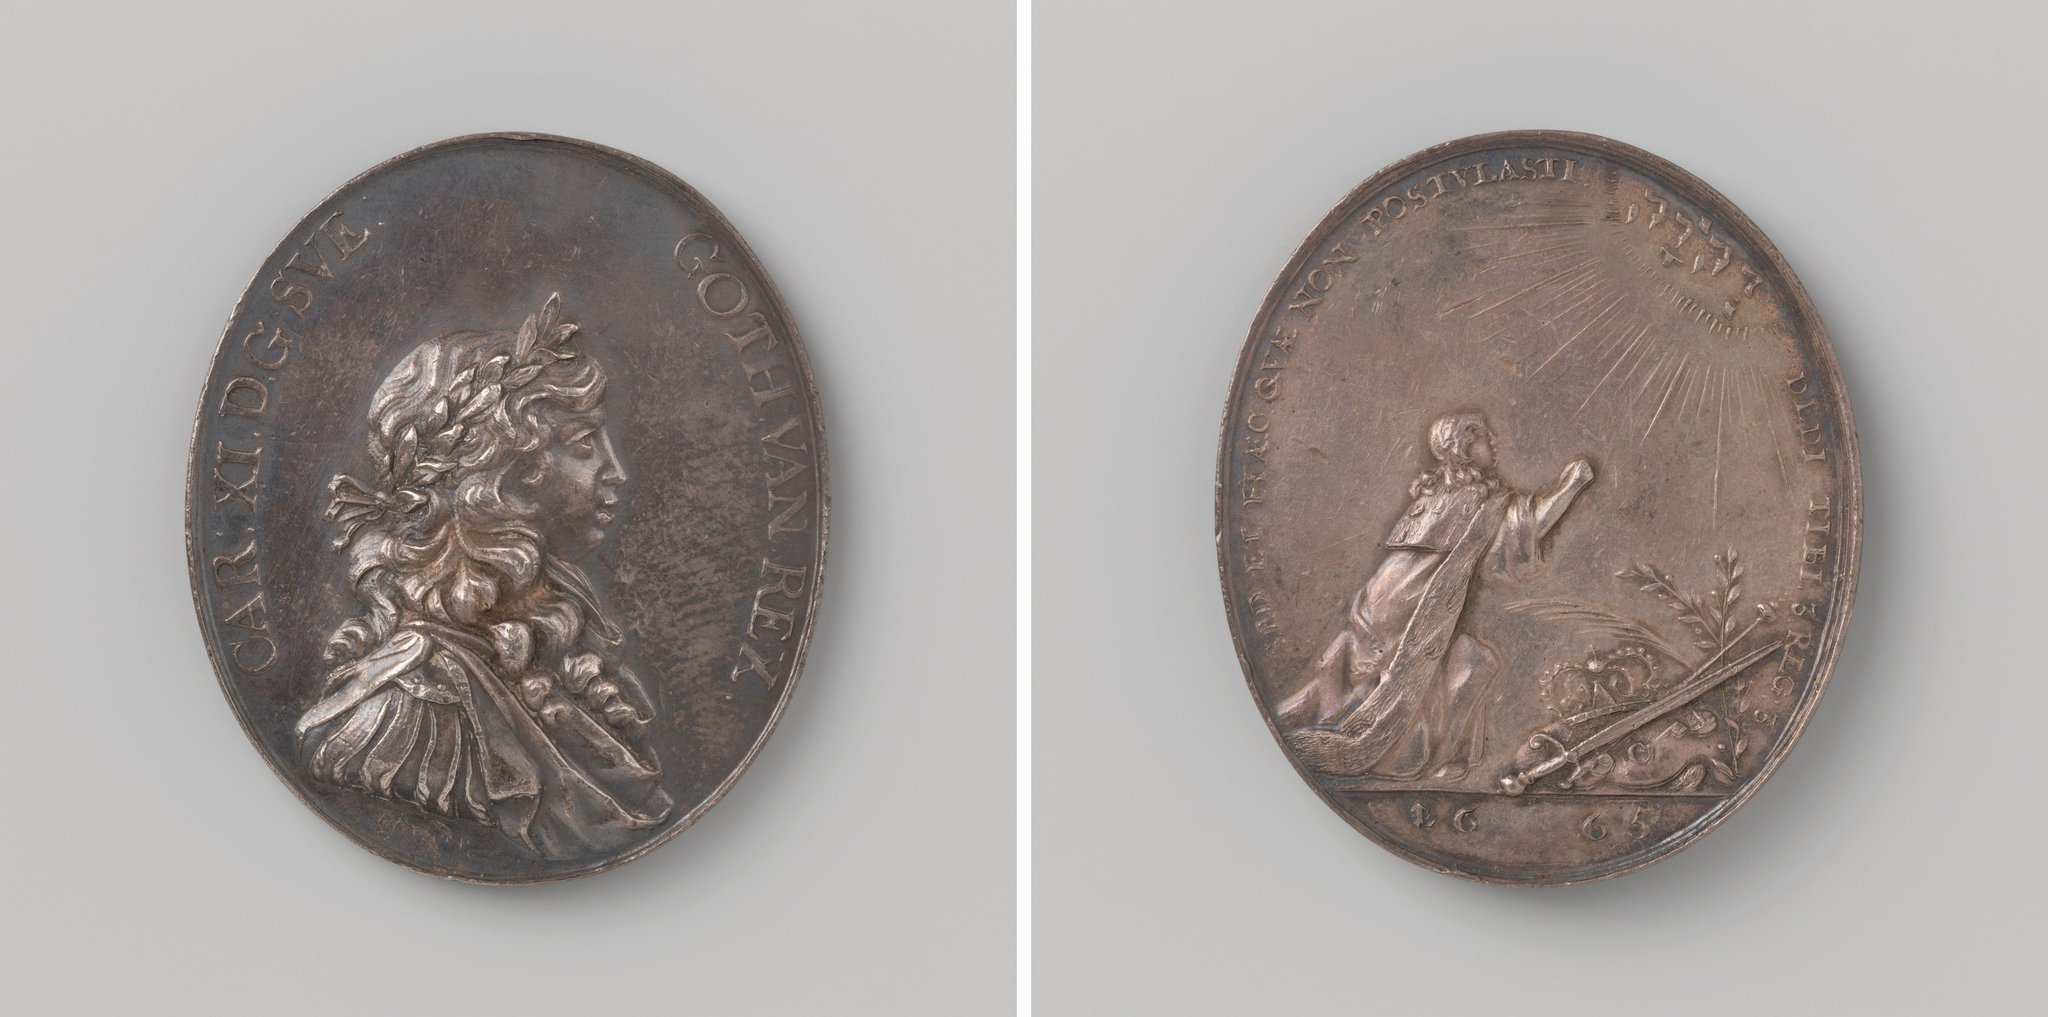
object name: history medal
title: Karel XI, koning van Zweden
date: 1665-1695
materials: silver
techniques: striking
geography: germany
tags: stockholm, koning, karel xi (koning van zweden)